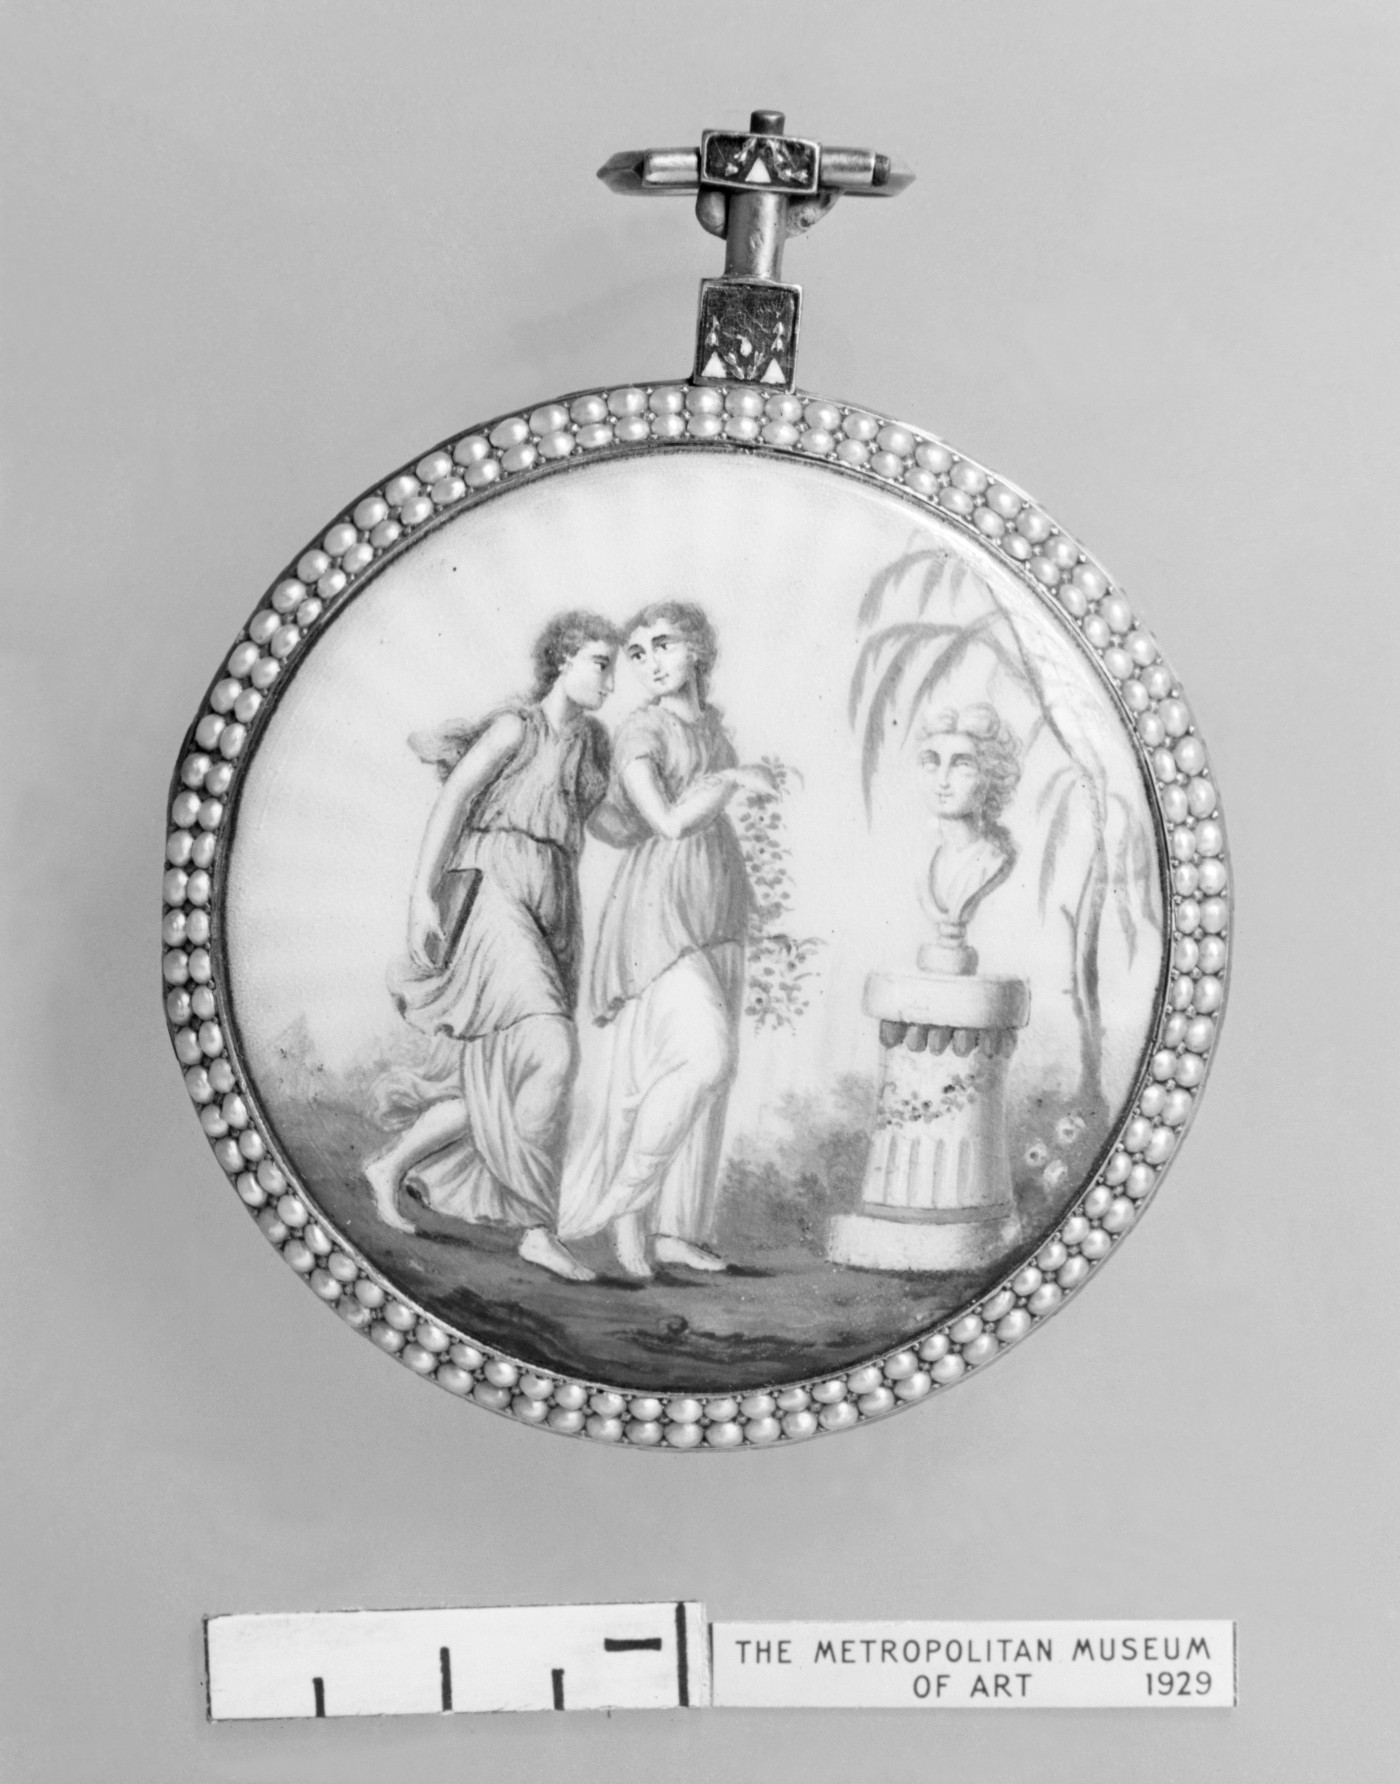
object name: watch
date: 1767-1800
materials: enamel, gold, pearl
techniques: enamel, painting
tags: men,women